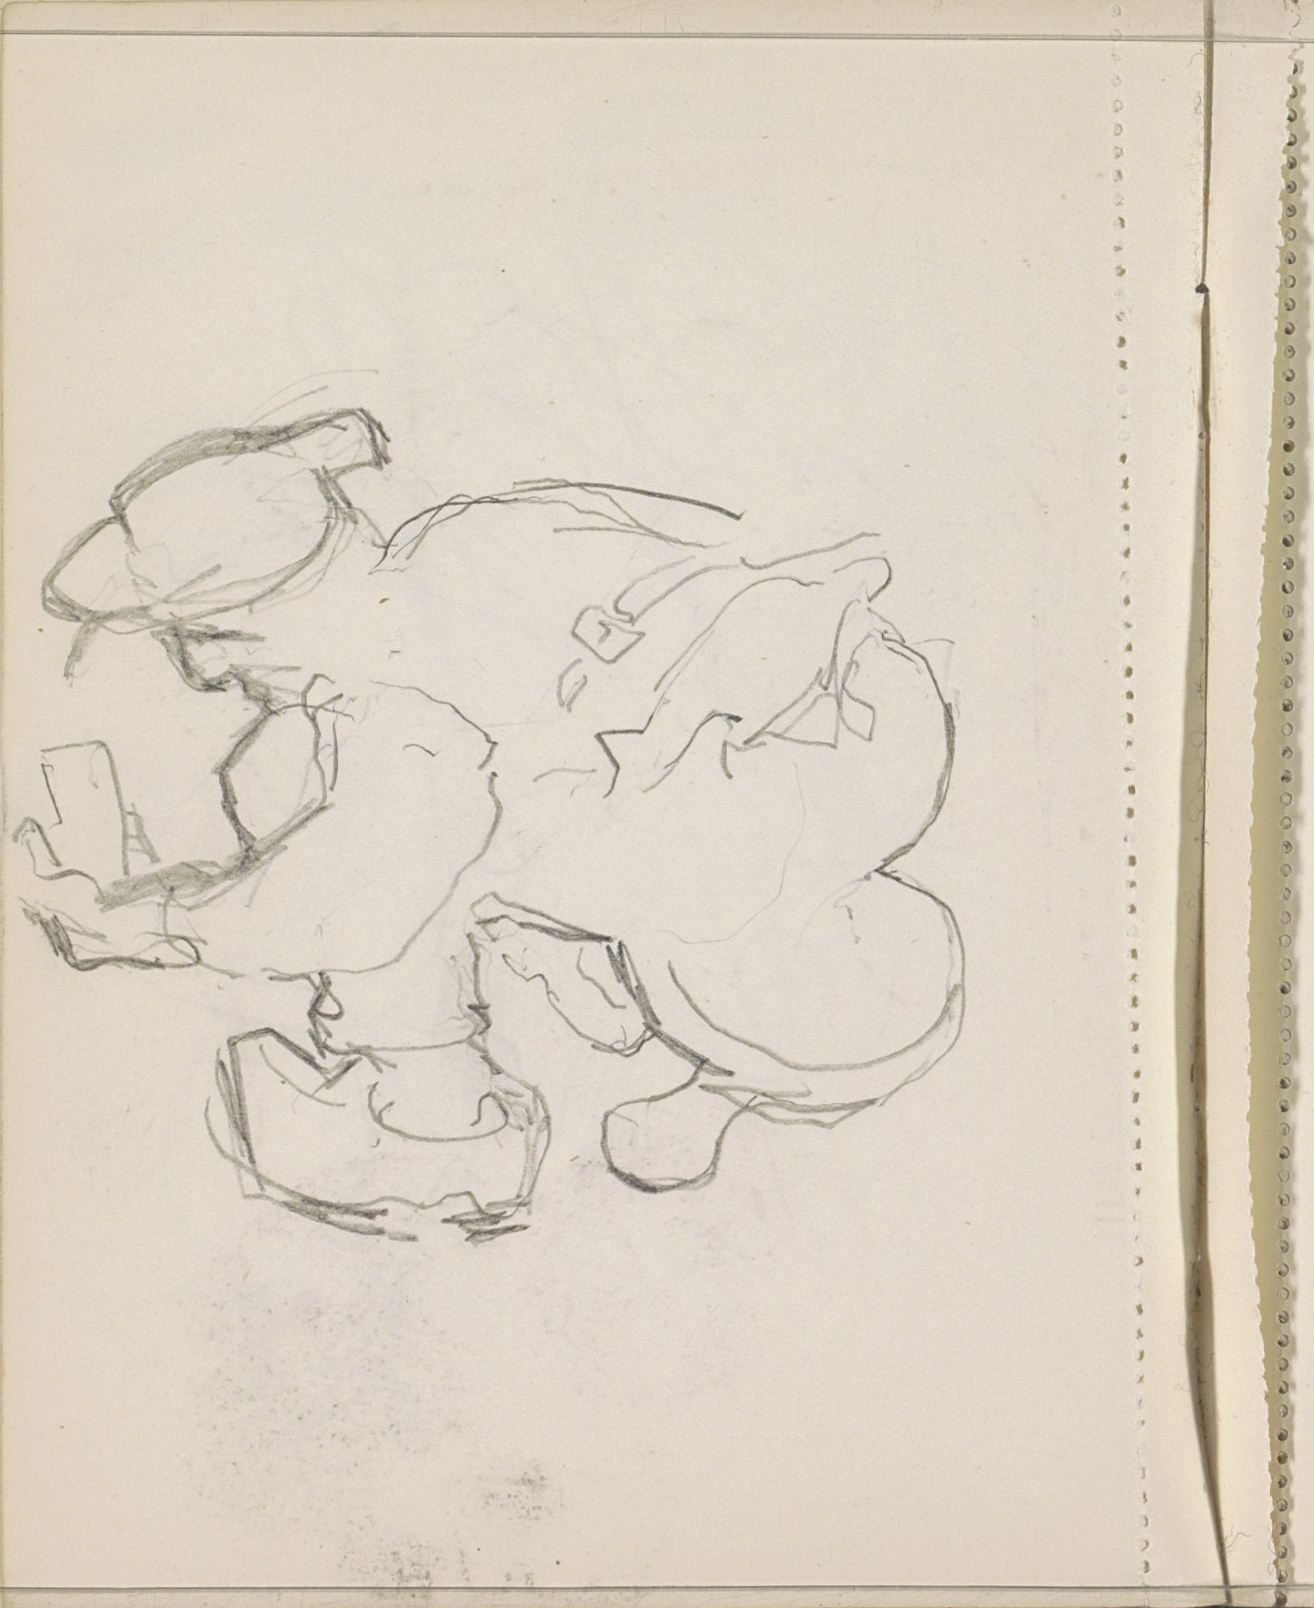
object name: sketchbook leaf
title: Knielende man op klompen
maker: reijer stolk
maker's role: draughtsman, print maker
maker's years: 1896-1945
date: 1906-1945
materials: paper, pencil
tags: wooden shoes, clogs, kneeling figure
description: Blad 21 verso uit een schetsboek met 42 bladen.